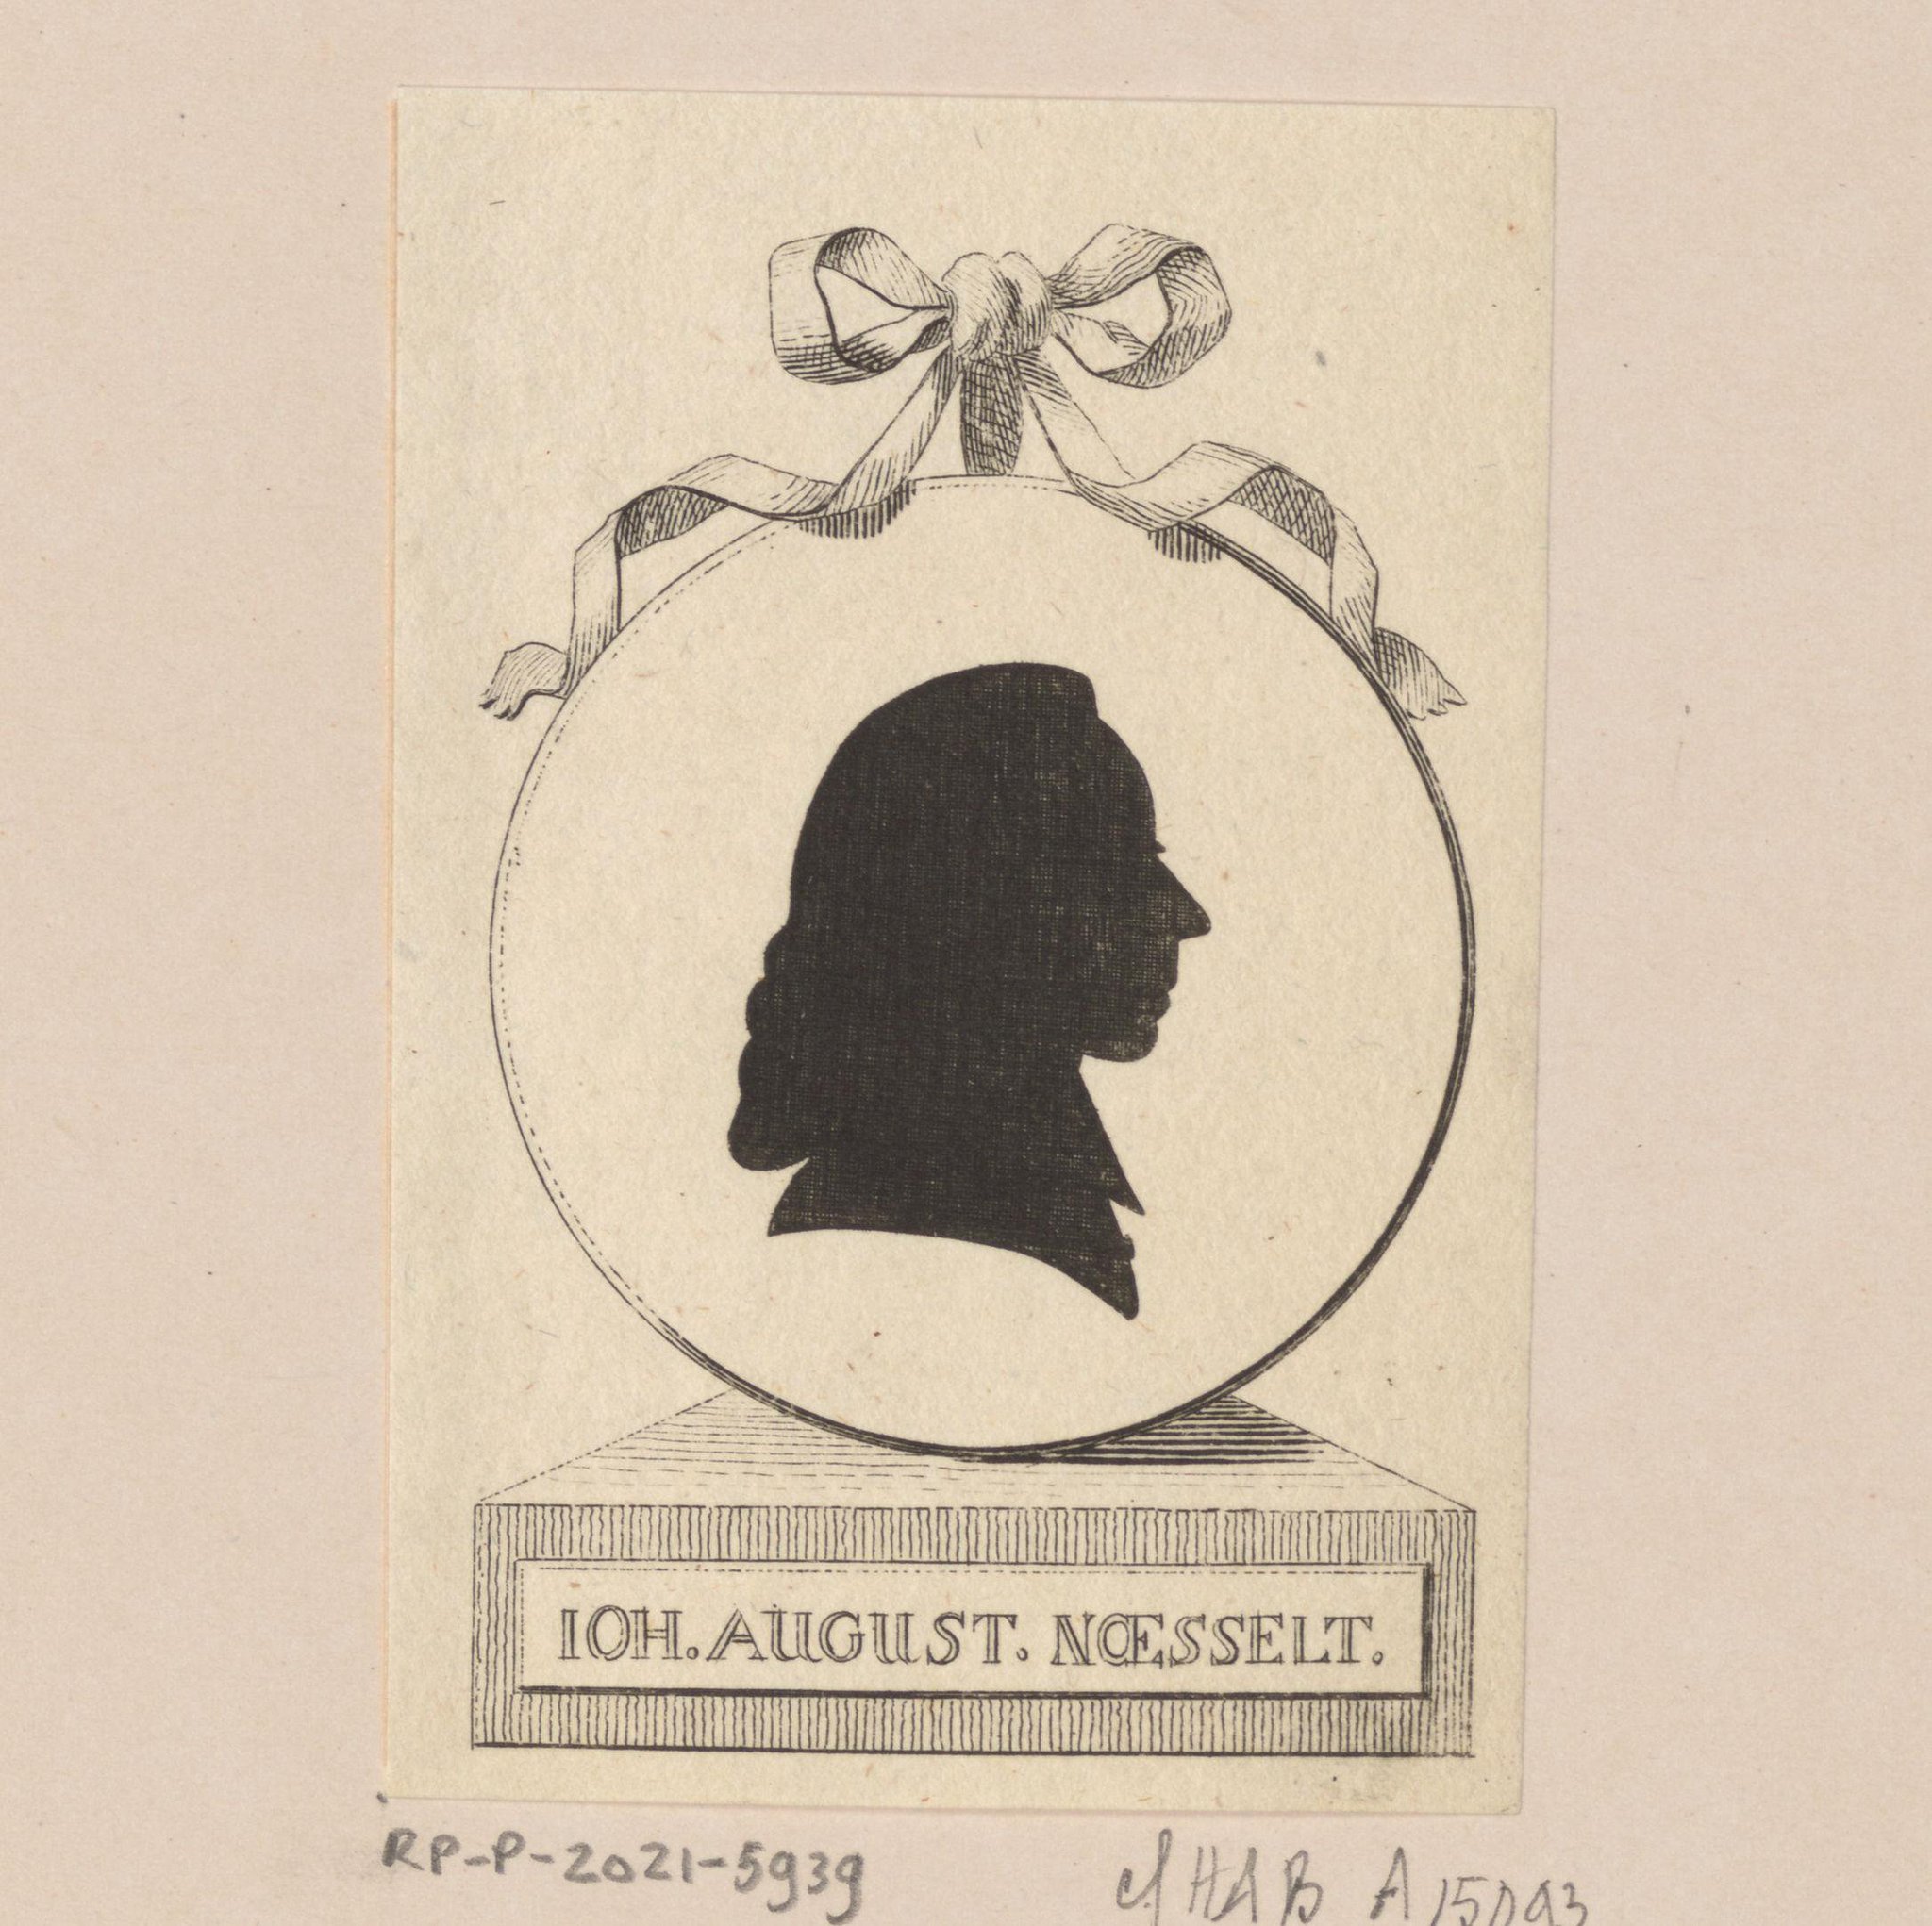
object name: print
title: Silhouetportret van Johann August Noesselt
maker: Anonymous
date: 1760-1820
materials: paper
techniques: etching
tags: historical persons